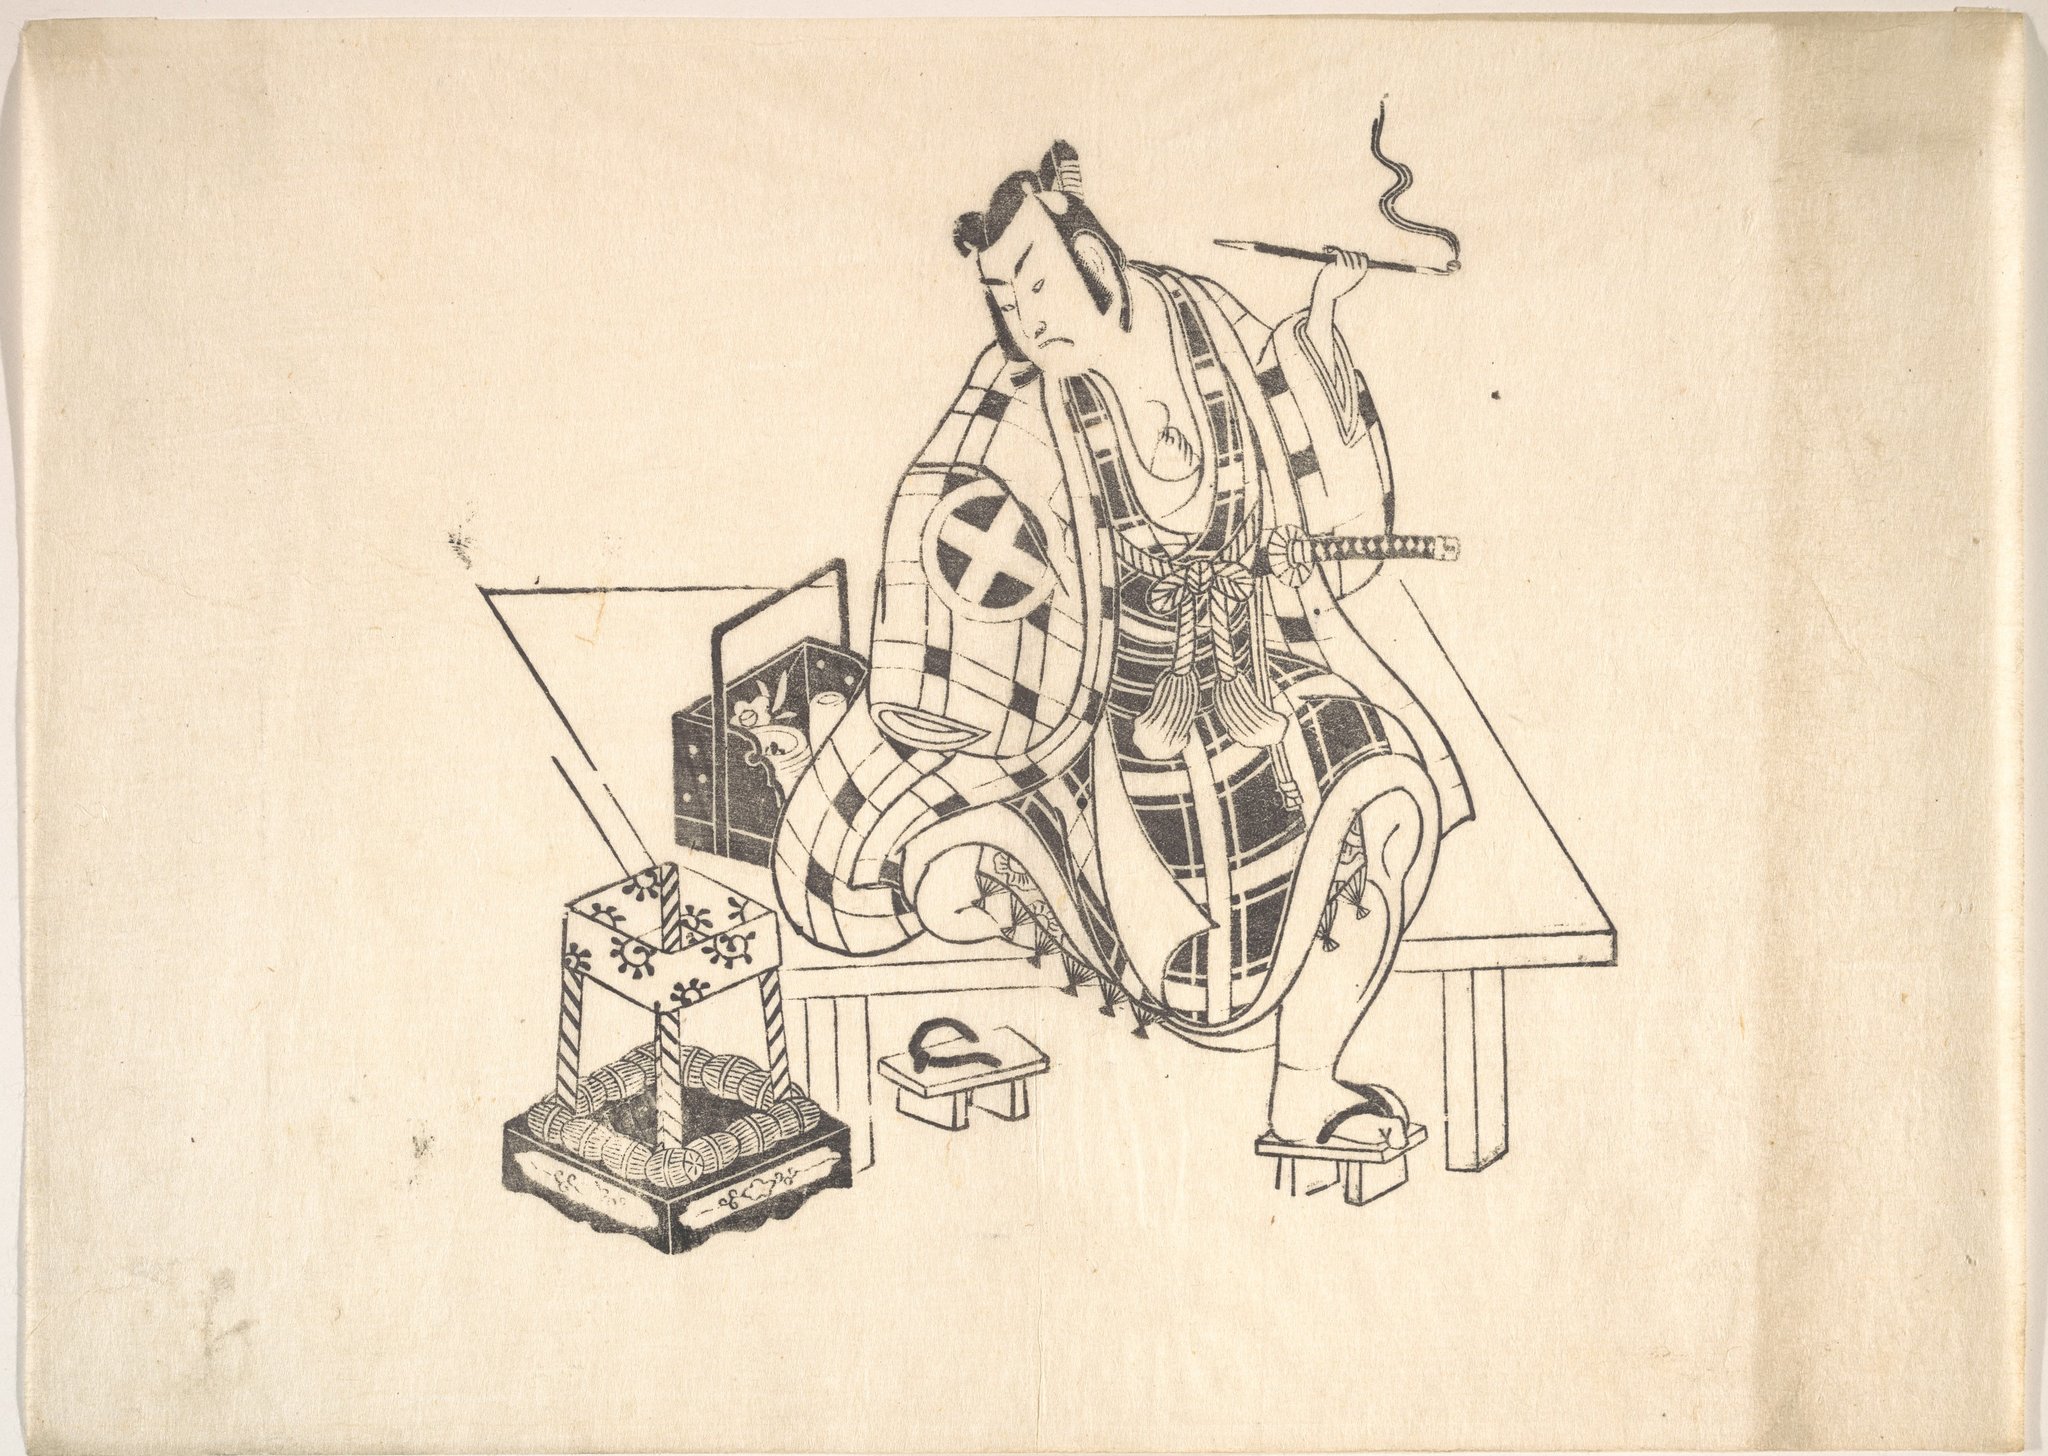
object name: print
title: One of Six Impressions from Worn Old Blocks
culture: japanese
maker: unidentified artist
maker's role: artist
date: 1700-1799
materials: ink, paper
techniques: woodblock print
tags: footwear,men,working